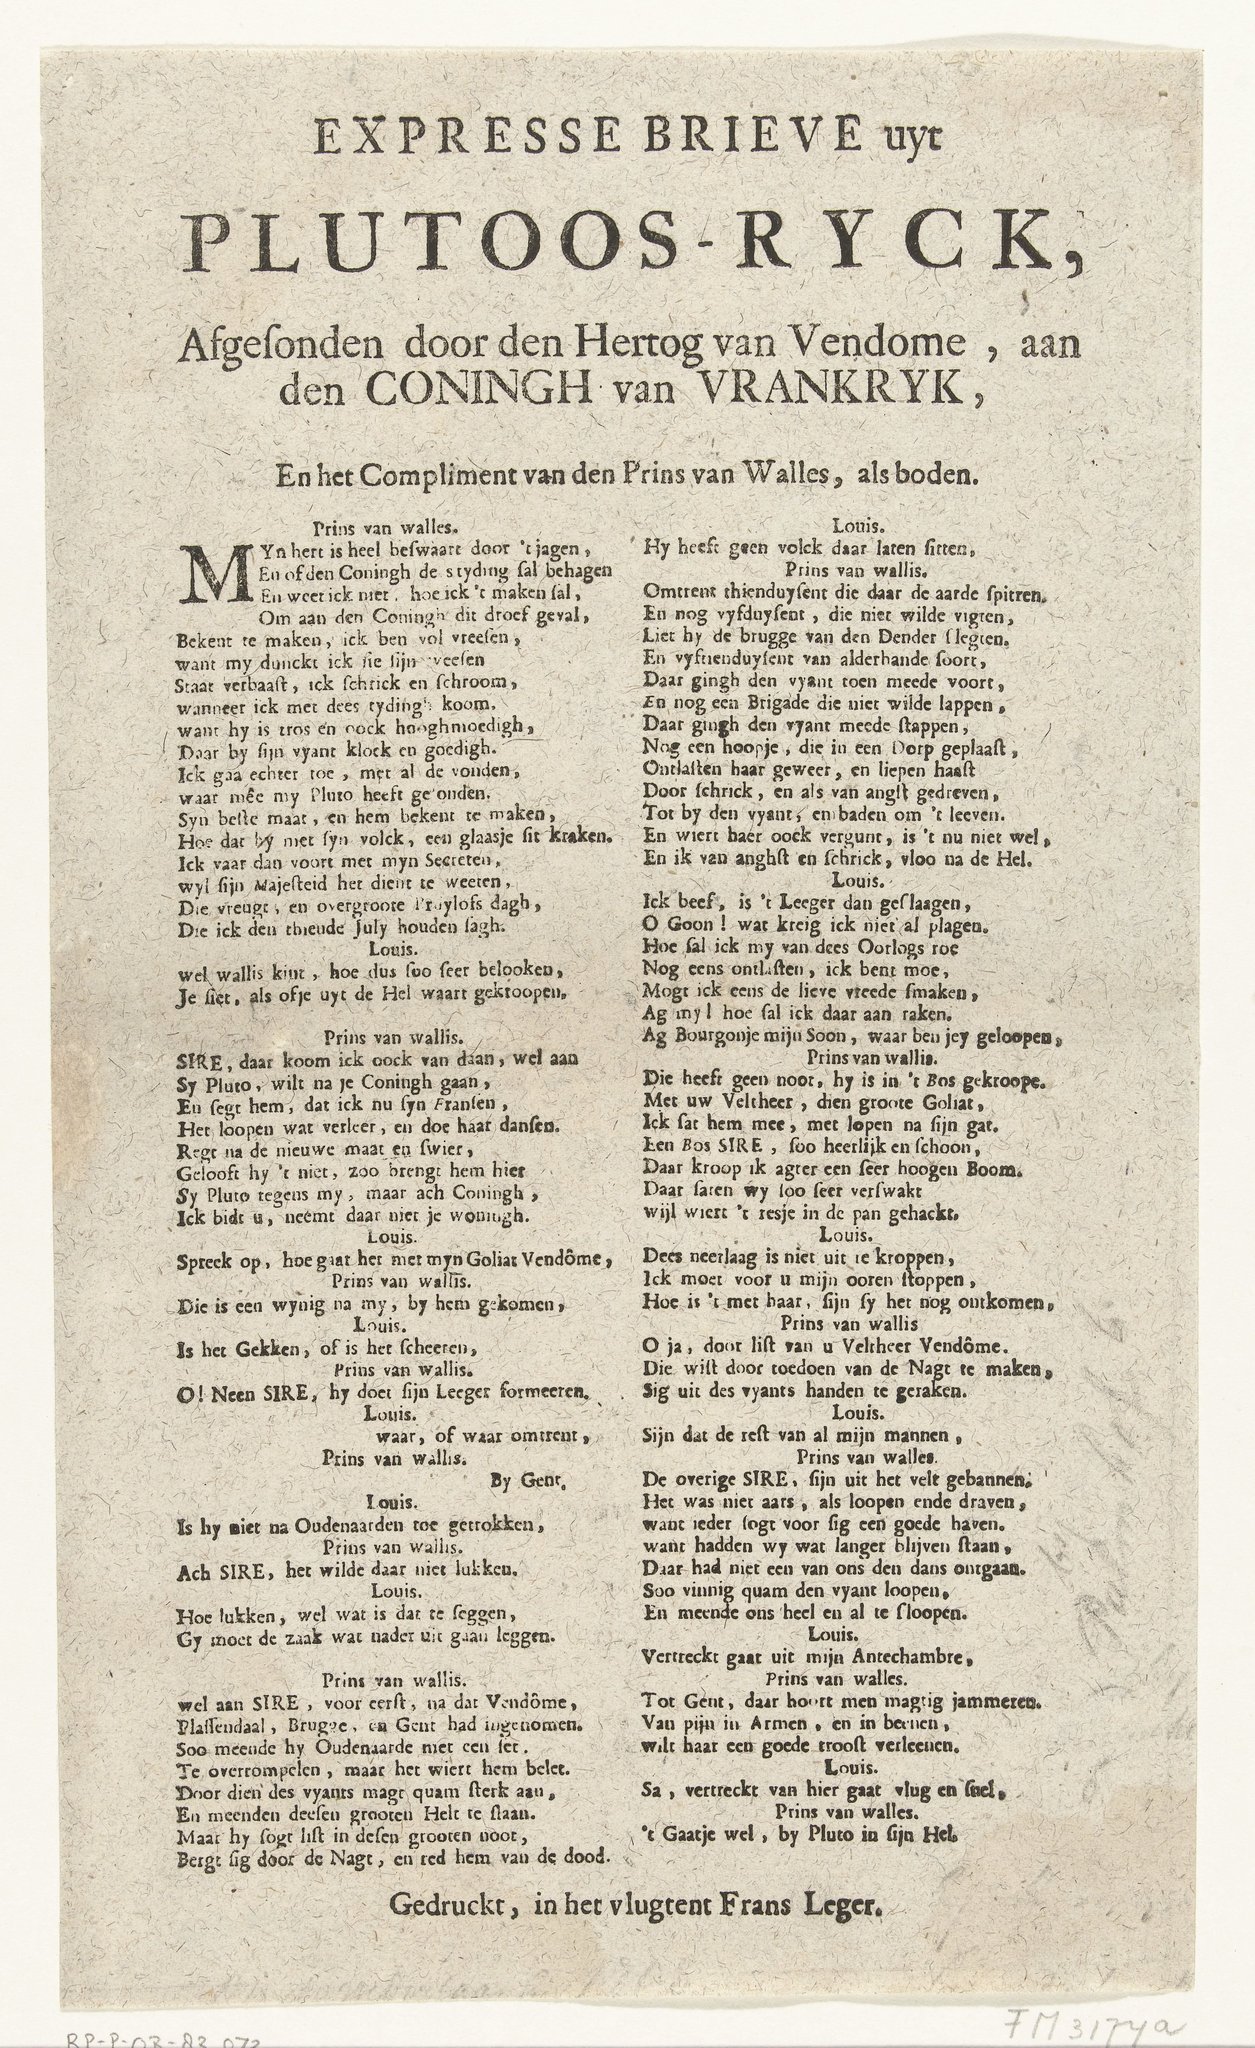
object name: text sheet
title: Spotbrief over het Franse verlies in de slag bij Oudenaarde, 1708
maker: carel allard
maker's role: print maker, publisher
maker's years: 1648-1709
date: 1708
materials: paper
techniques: letterpress printing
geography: northern netherlands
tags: lodewijk xiv (koning van frankrijk), paris, london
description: Spotvers in de vorm van een brief van de hertog van Vendôme aan koning Lodewijk XIV met de prins van Wales als bode, over het Franse verlies in de slag bij Oudenaarde, 11 juli 1708. Onderdeel van een reeks getiteld Palmhof der Bondgenooten met 9 spotprenten op de Fransen en bondgenoten uit het jaar 1708.